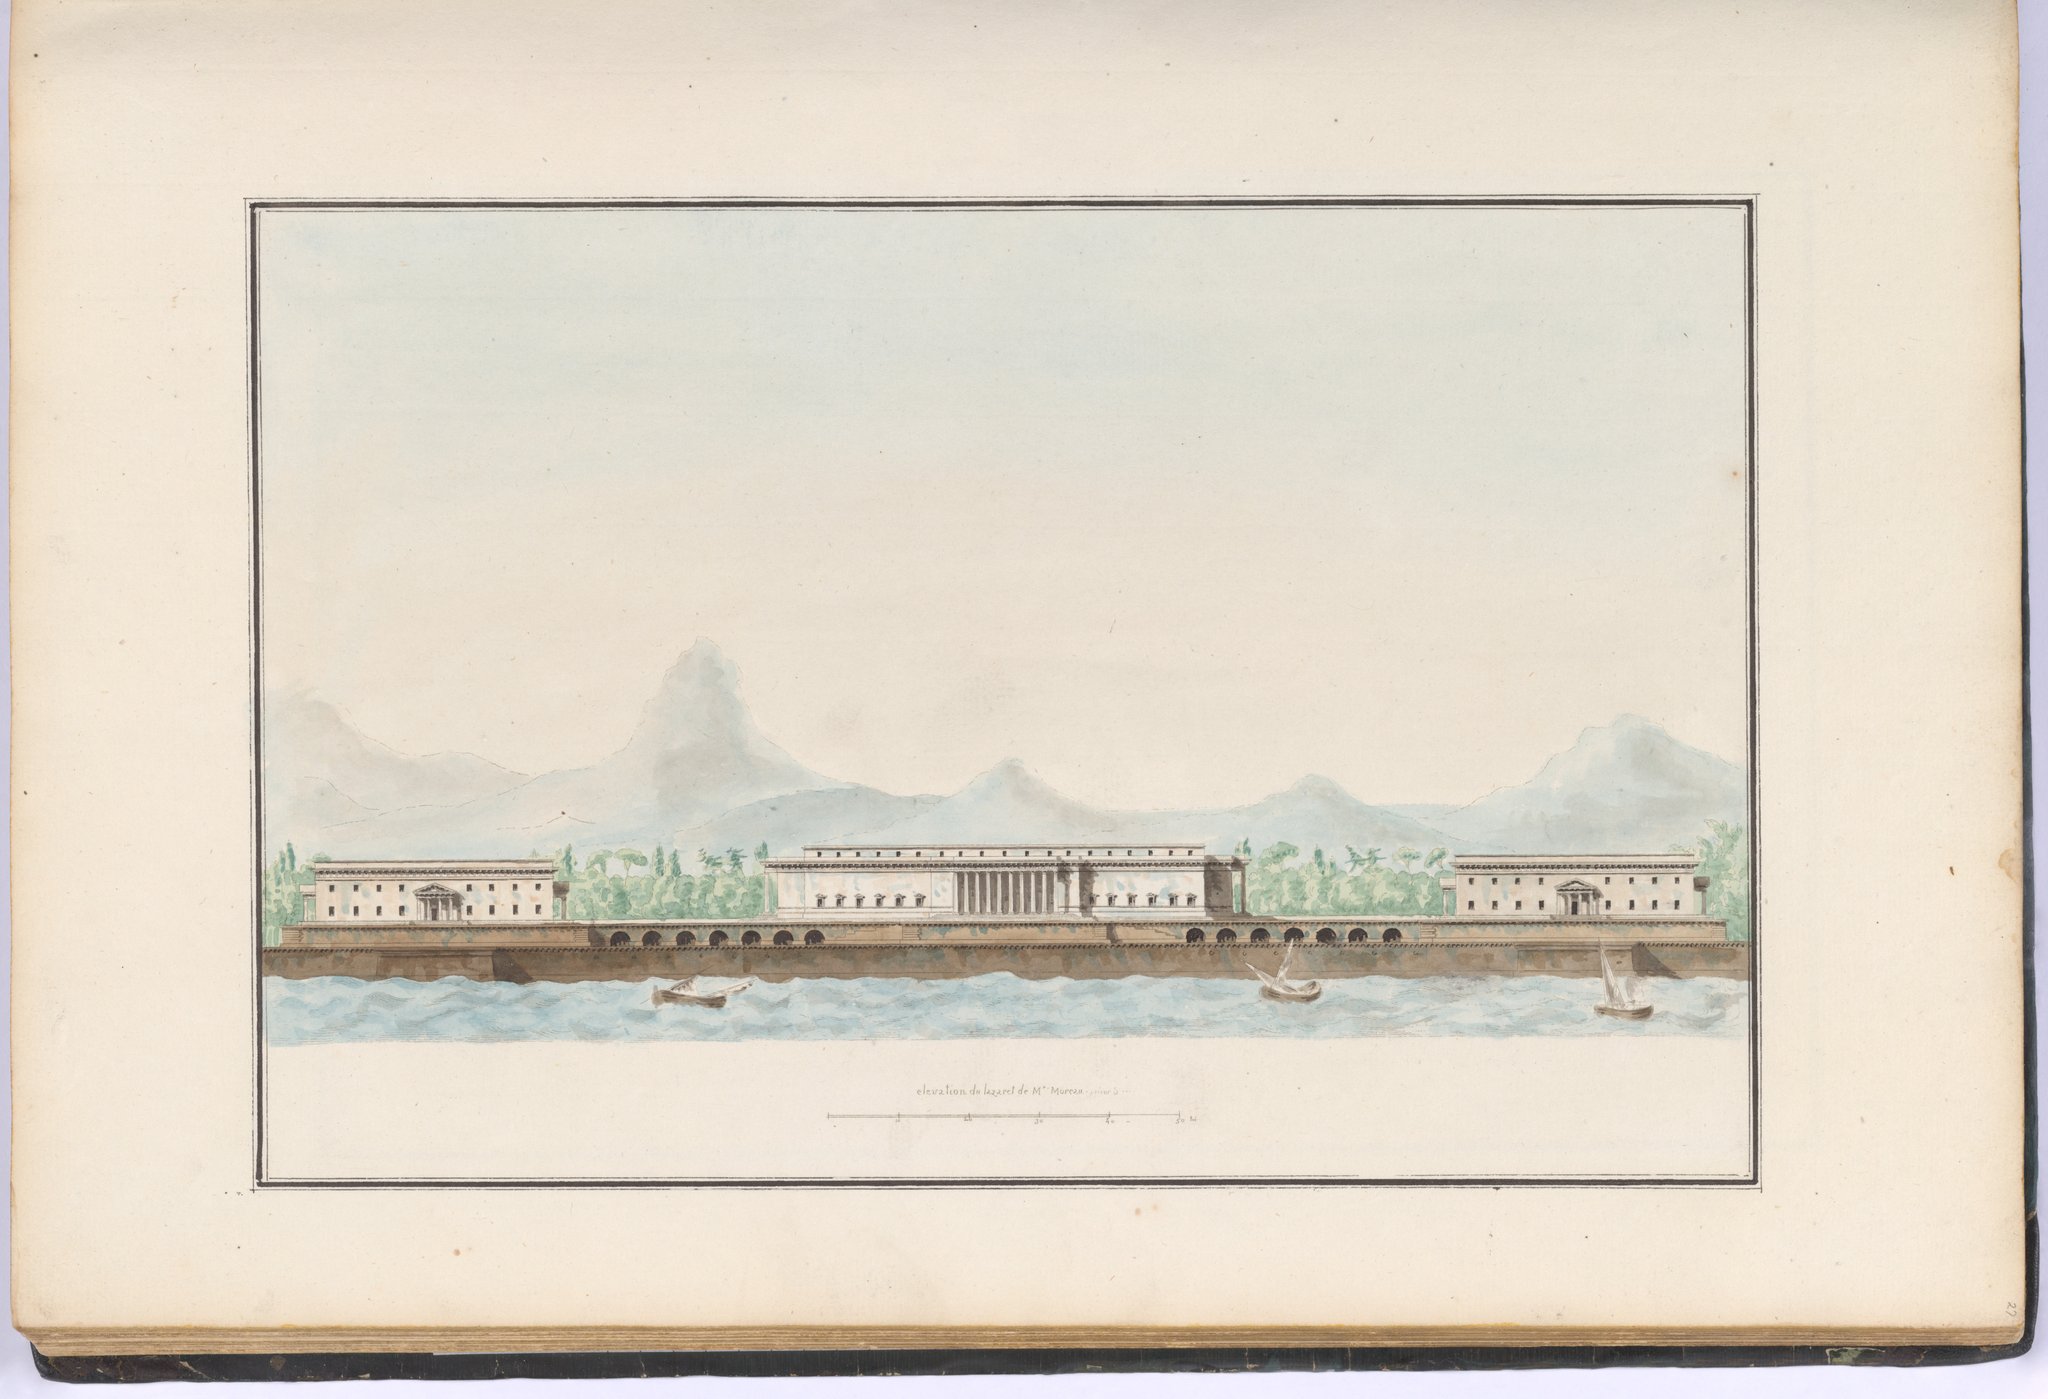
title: Collection des Prix que la ci-devant Académie d'Architecture proposoit et couronnoit tous les ans.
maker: prieur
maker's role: engraver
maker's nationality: french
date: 1787-1796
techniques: etching, hand coloring, printing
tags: architecture,buildings